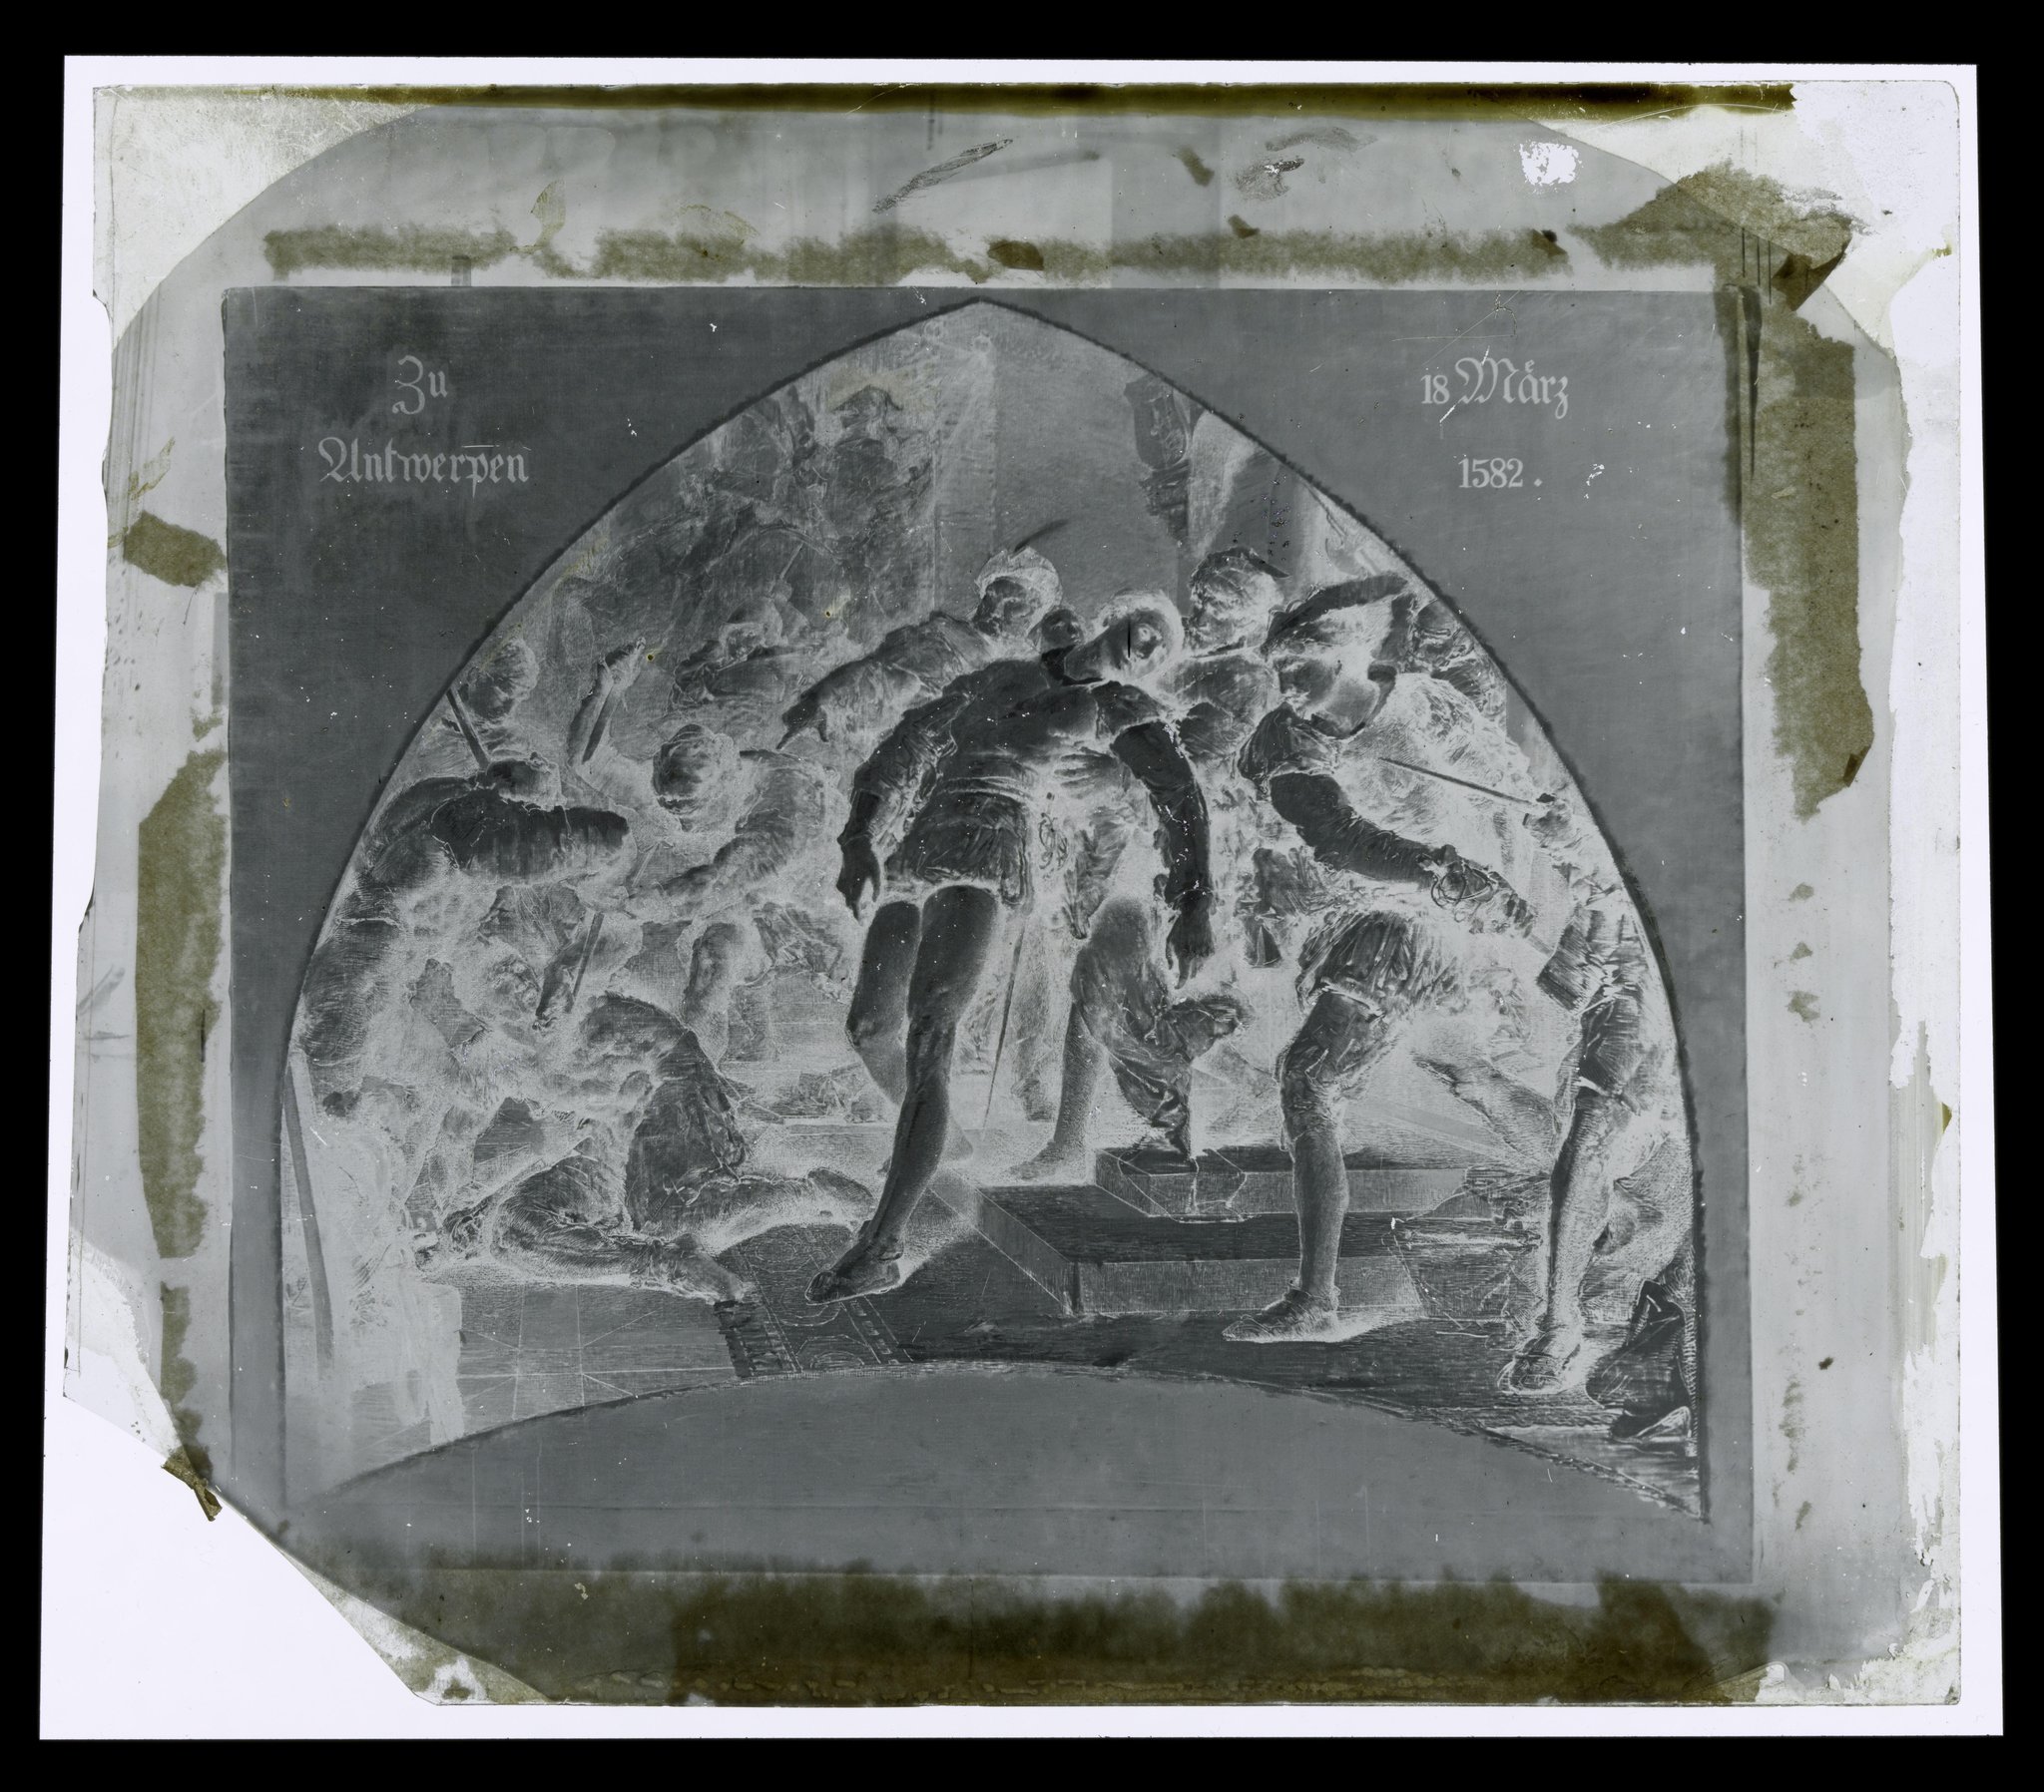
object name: glasnegatief, glasplaatnegatief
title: Fotoreproductie van een schilderij van de aanslag op Willem van Oranje in Antwerpen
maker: laurens lodewijk kleijn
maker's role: draughtsman, painter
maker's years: 1826-1909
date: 1884-1900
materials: glass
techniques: collodion process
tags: delft, william i (prince of orange), piece of sculpture, reproduction of a piece of sculpture, attempt, political murder, antwerp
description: Onderdeel van een groep glasnegatieven uit de nalatenschap van de schilder Laurens Lodewijk Kleijn, met stillevens, portretten, zelfportretten en kunstreproducties.